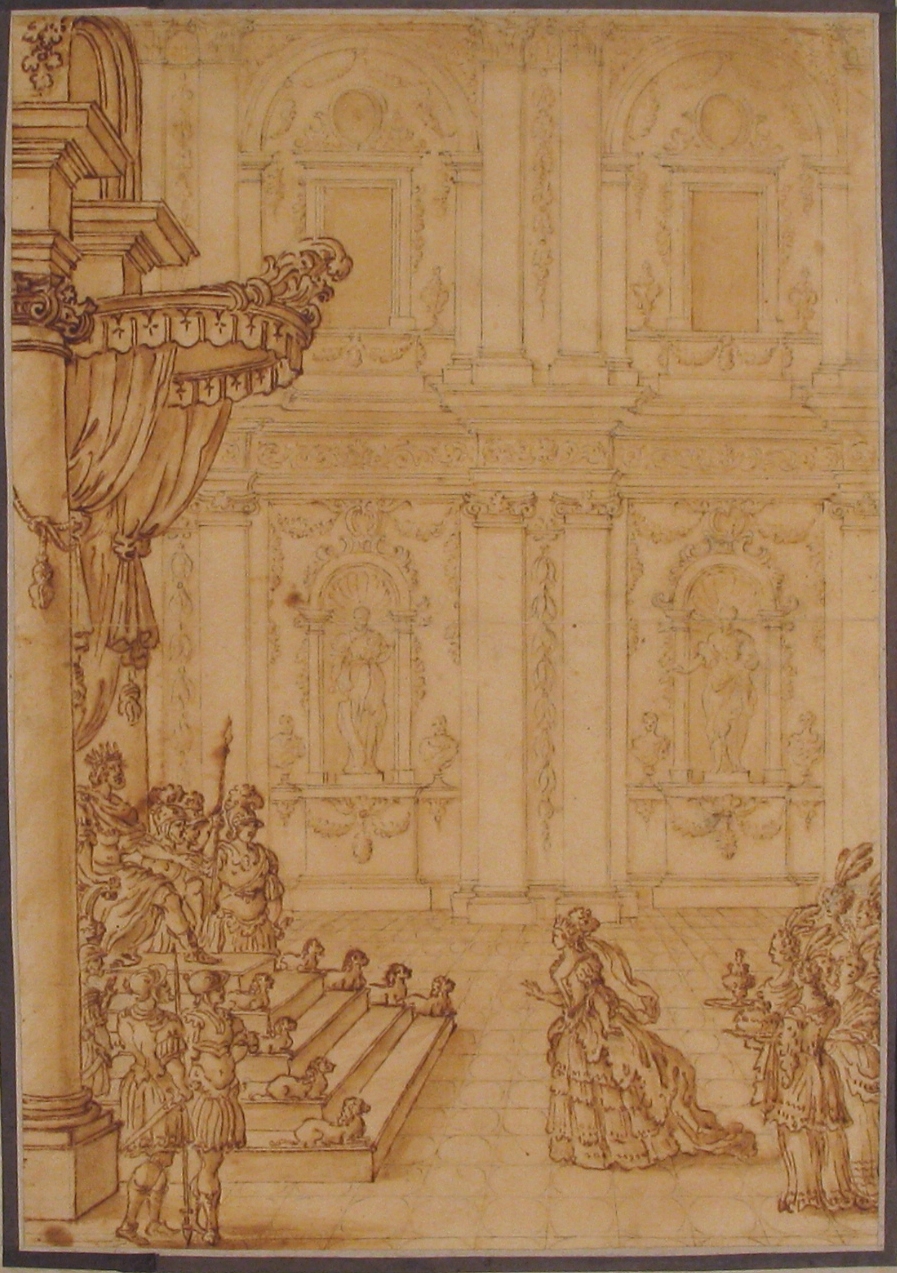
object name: drawing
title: Esther before Ahasuerus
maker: anonymous, french, 18th century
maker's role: artist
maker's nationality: french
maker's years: 1700-1800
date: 1667-1733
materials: graphite, ink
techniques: brush, pen, wash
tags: soldiers,kings,men,women,esther,ahasuerus